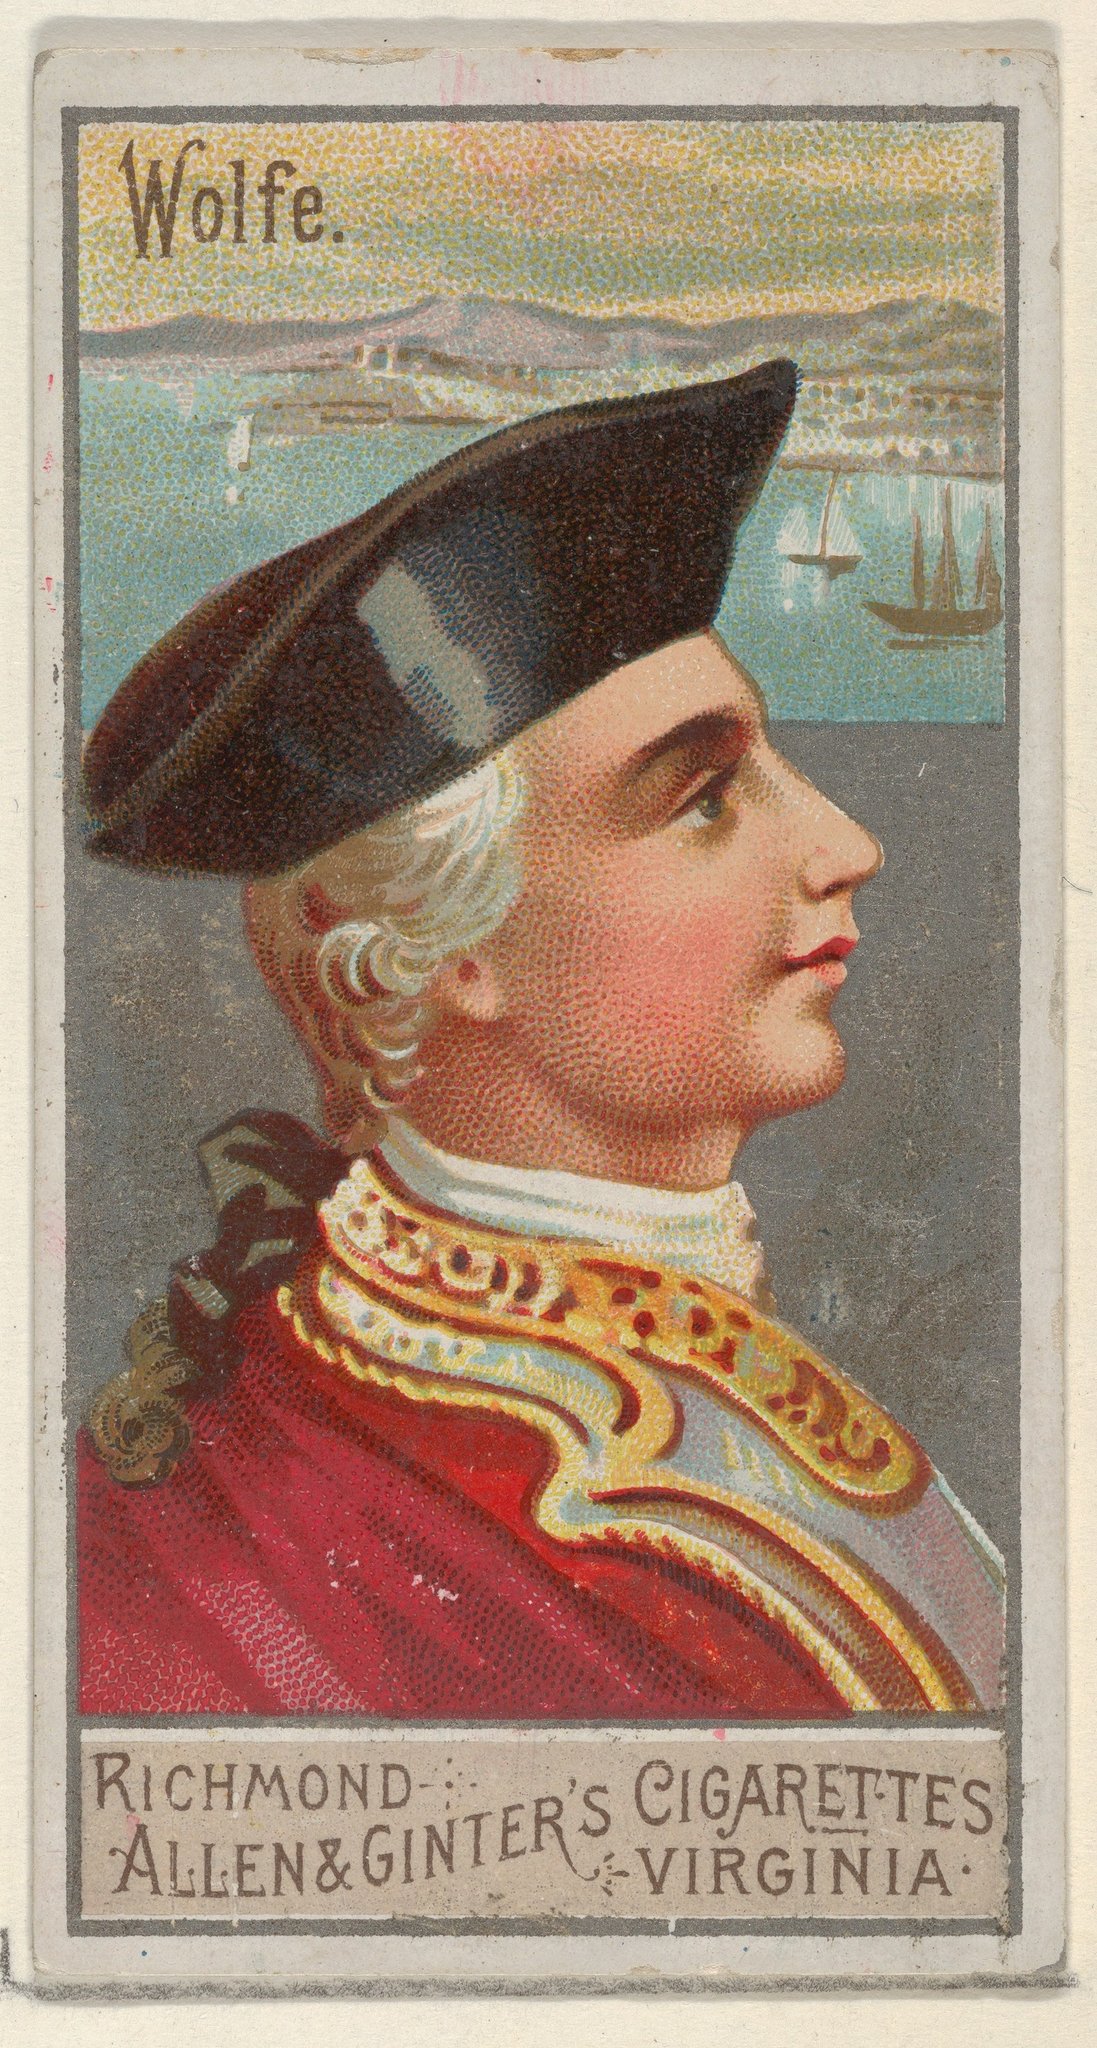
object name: print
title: James P. Wolfe, from the Great Generals series (N15) for Allen & Ginter Cigarettes Brands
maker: allen & ginter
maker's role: publisher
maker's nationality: american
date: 1888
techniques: color lithograph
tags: men,profiles,generals